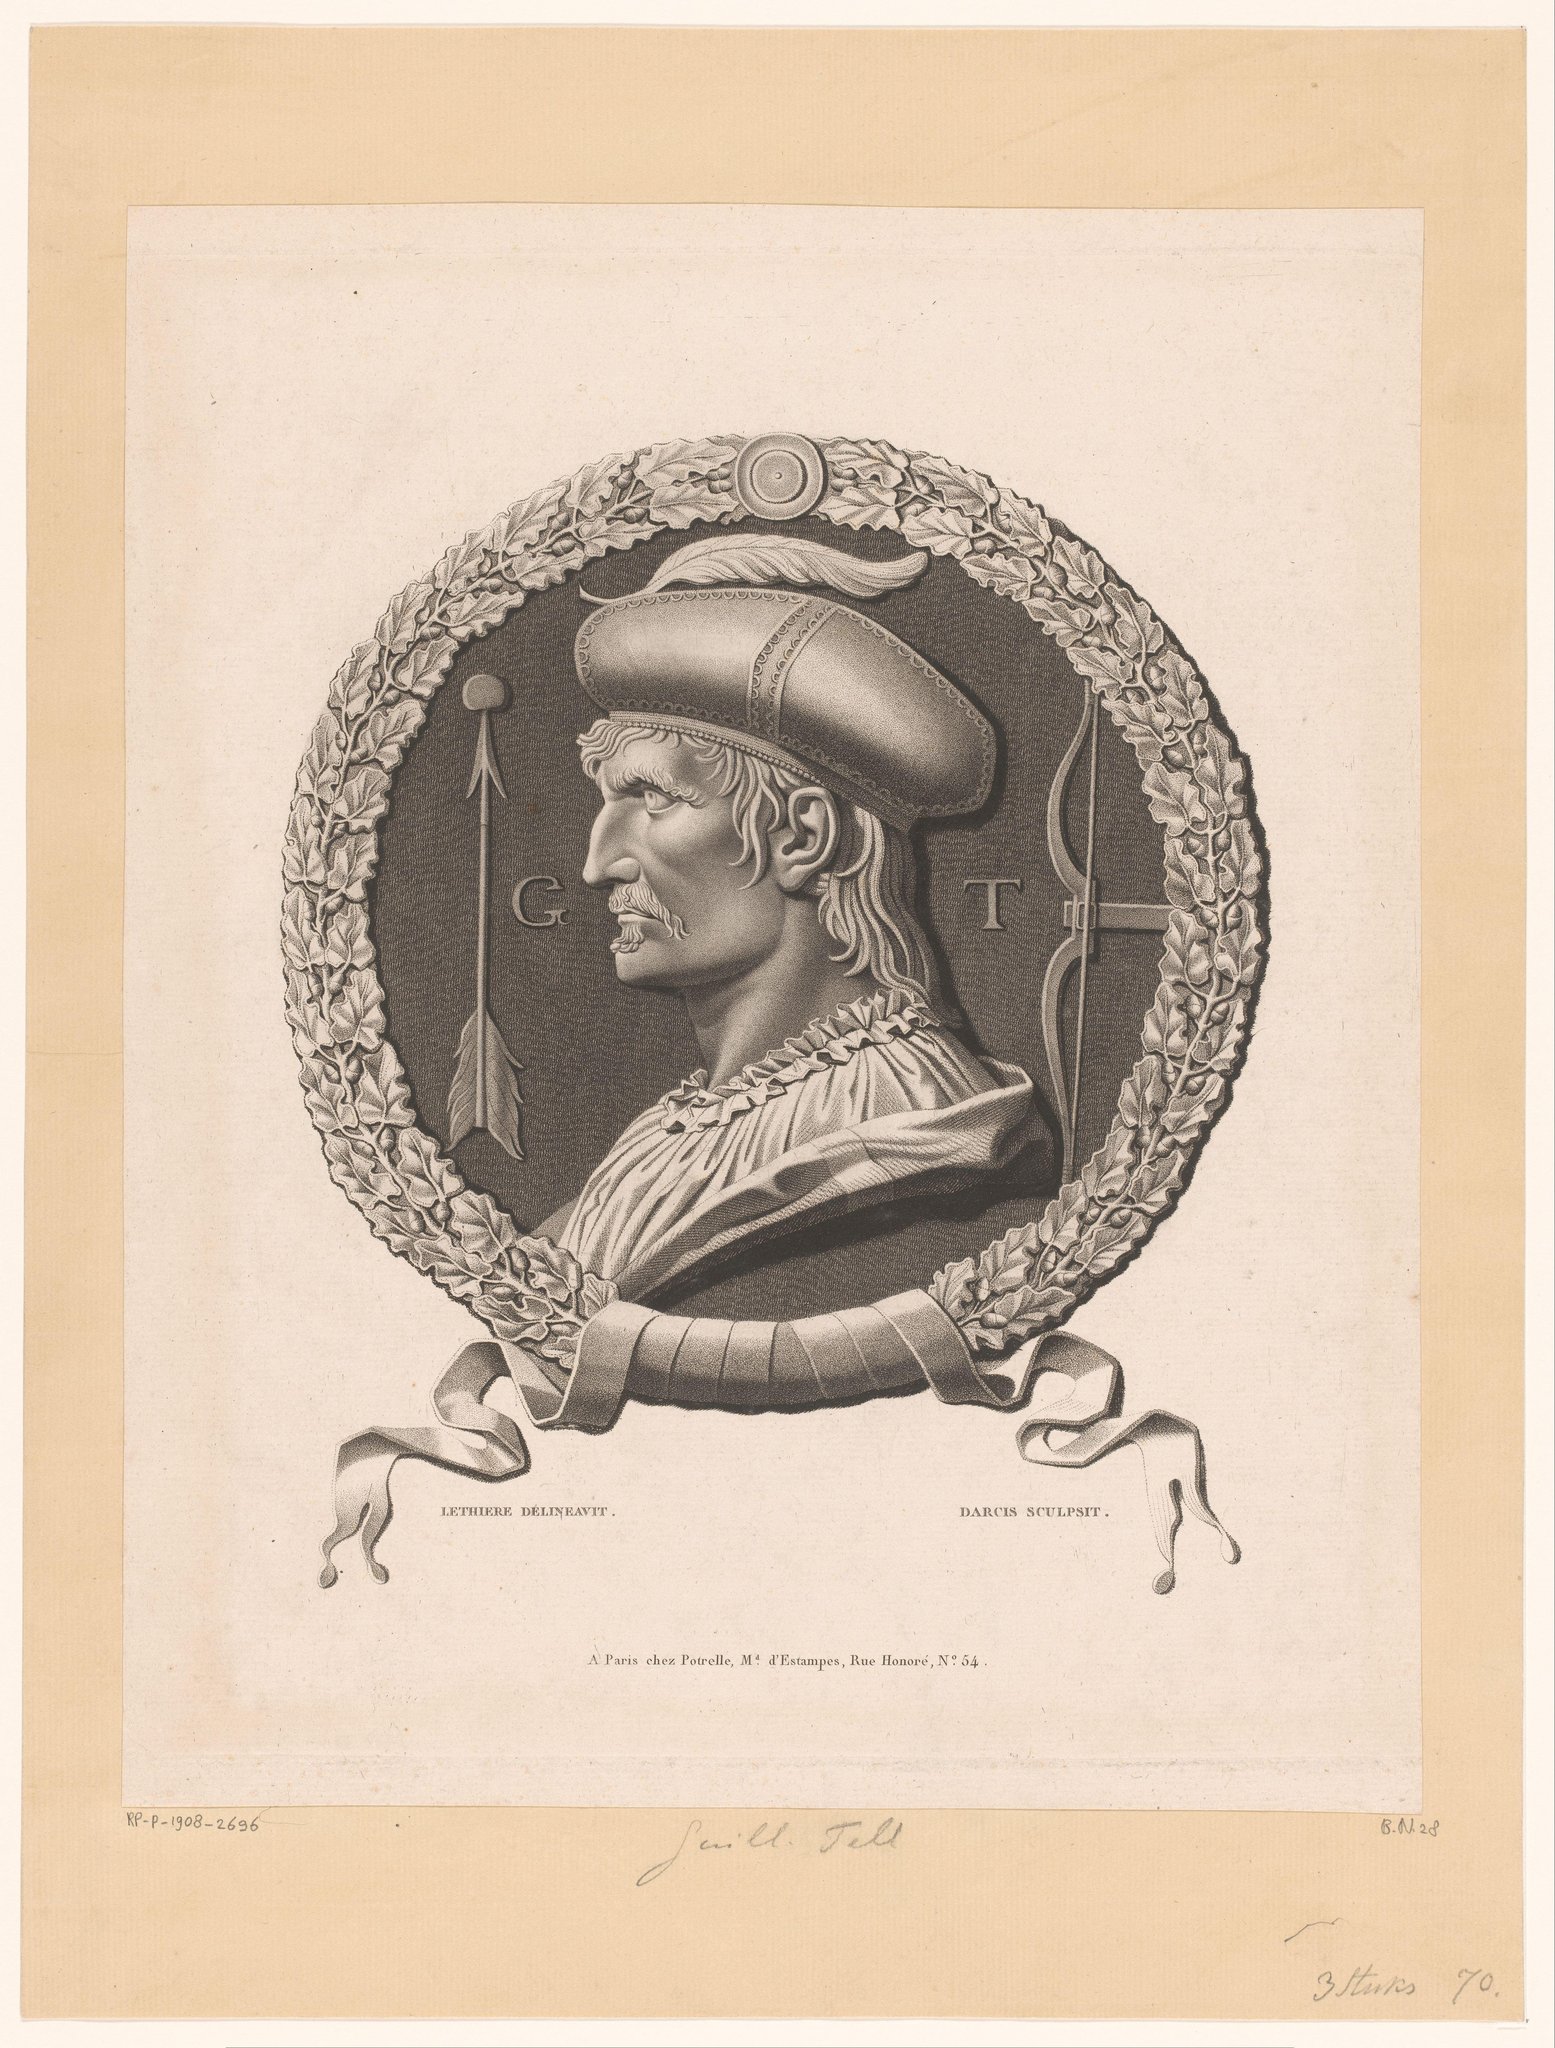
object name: print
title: Portret van William Tell in medaillon met pijl en boog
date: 1787-1801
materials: paper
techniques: etching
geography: france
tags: historical persons, archer's weapons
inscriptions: collector's mark: Lugt 2228